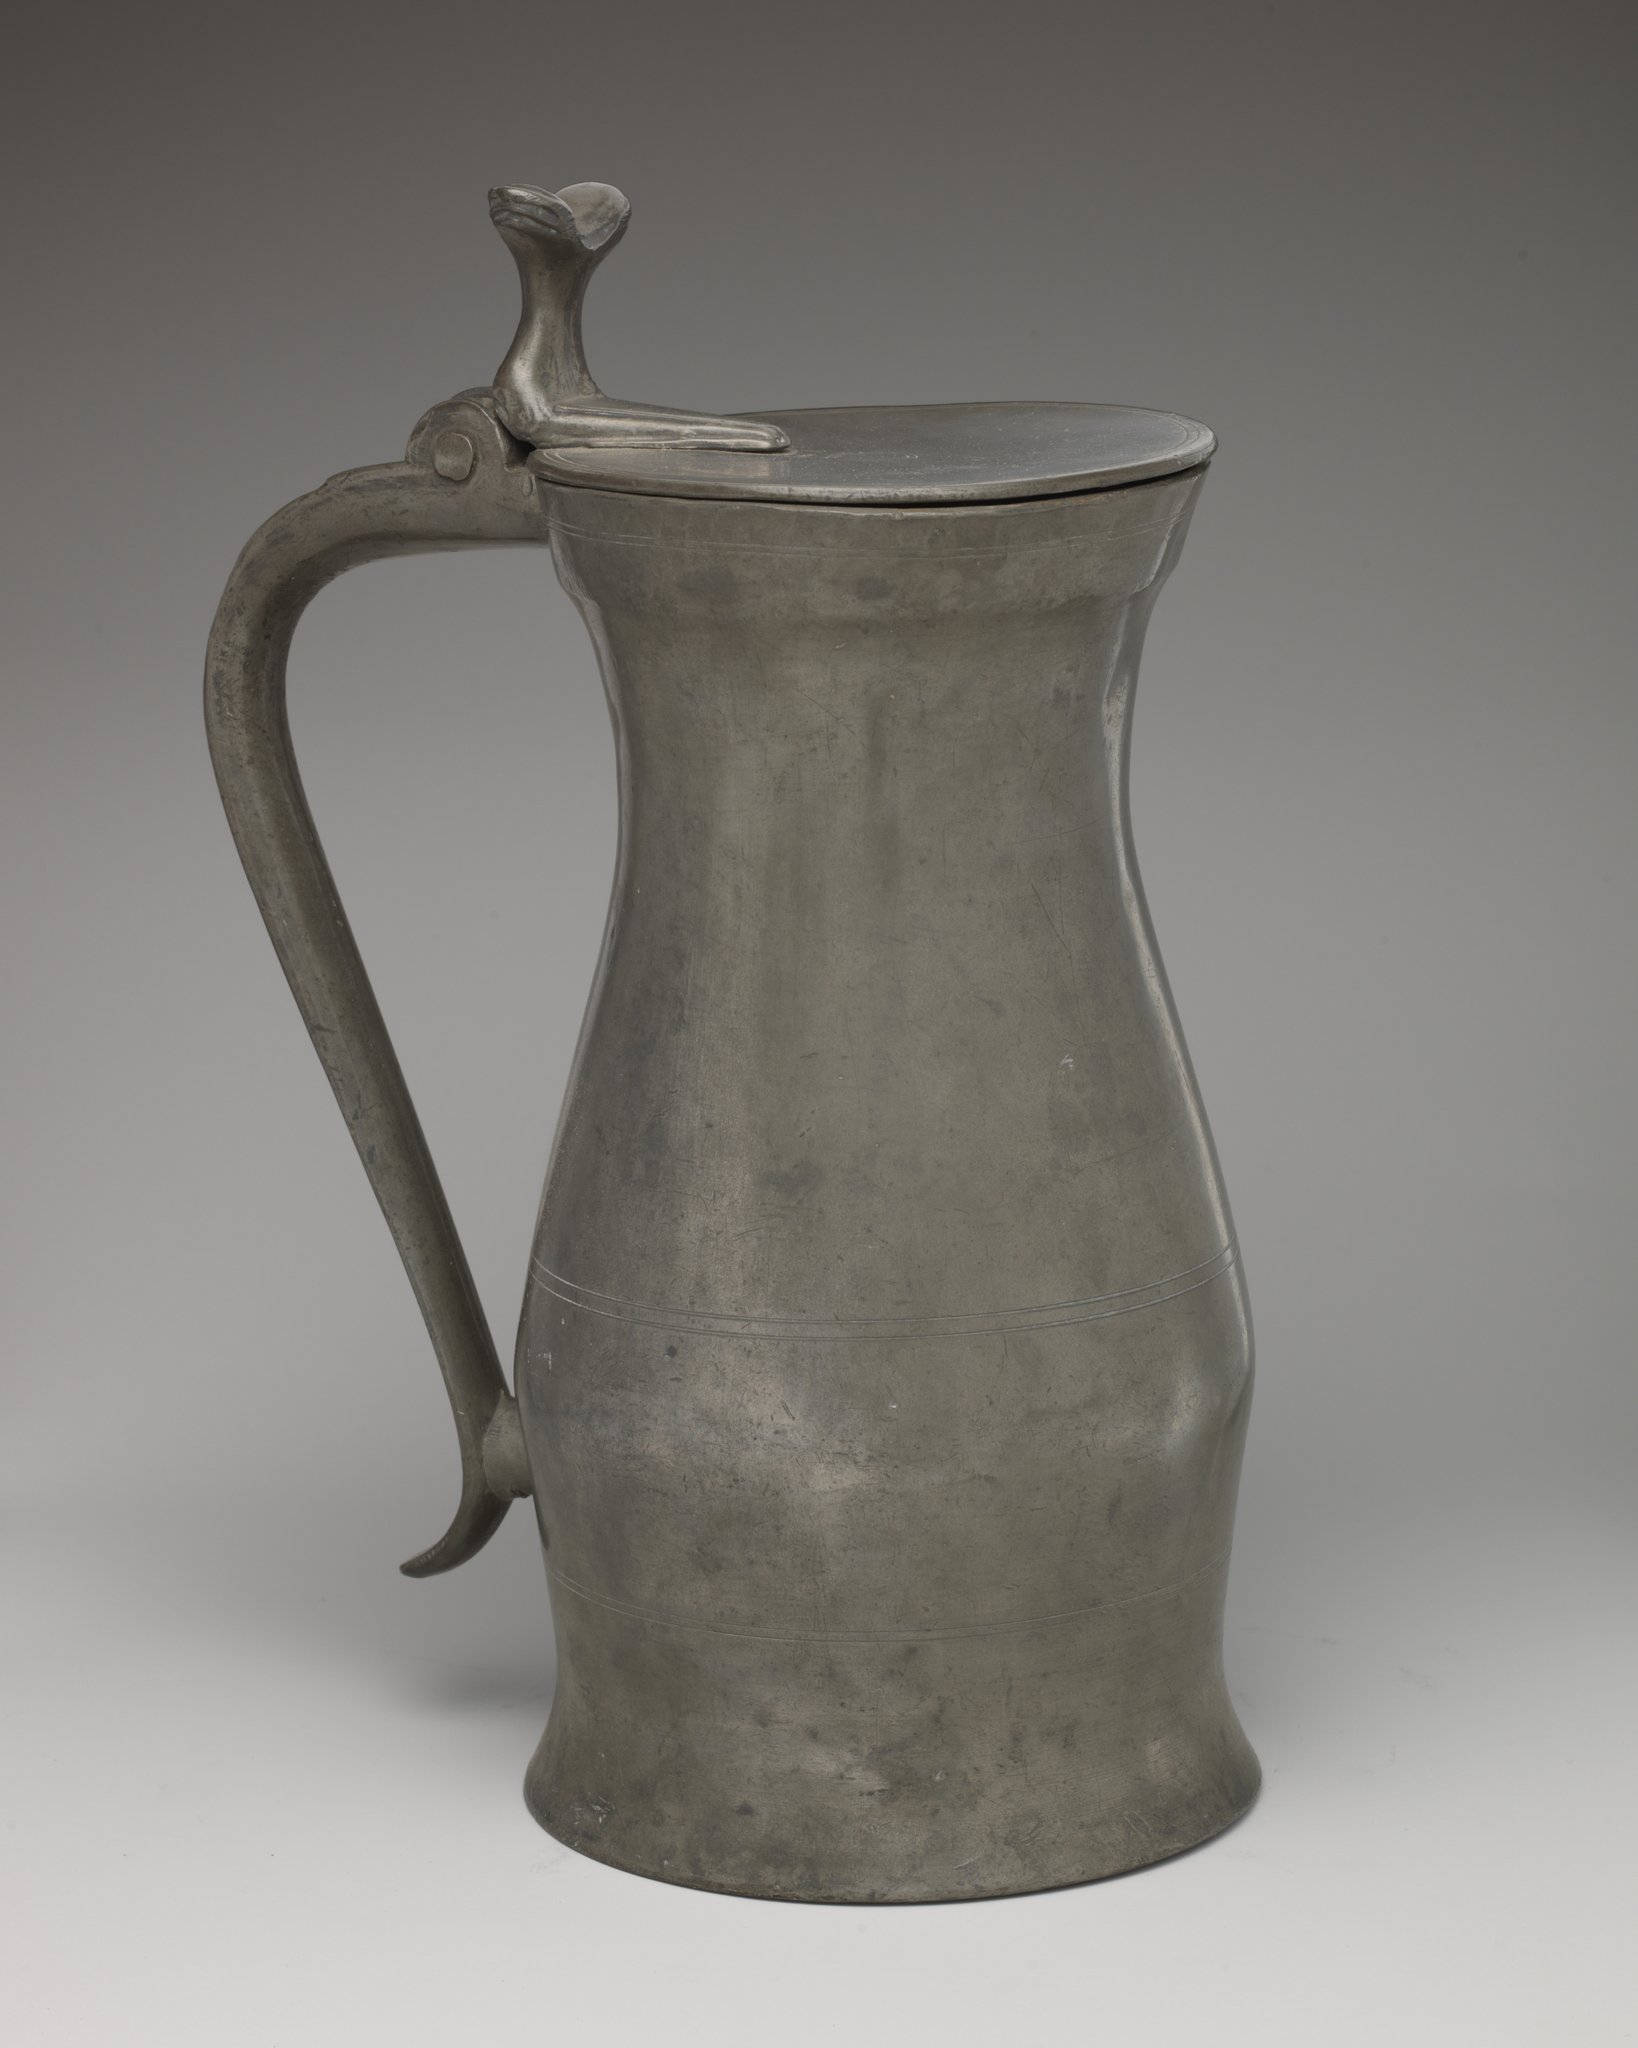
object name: measure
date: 1701-1800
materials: pewter